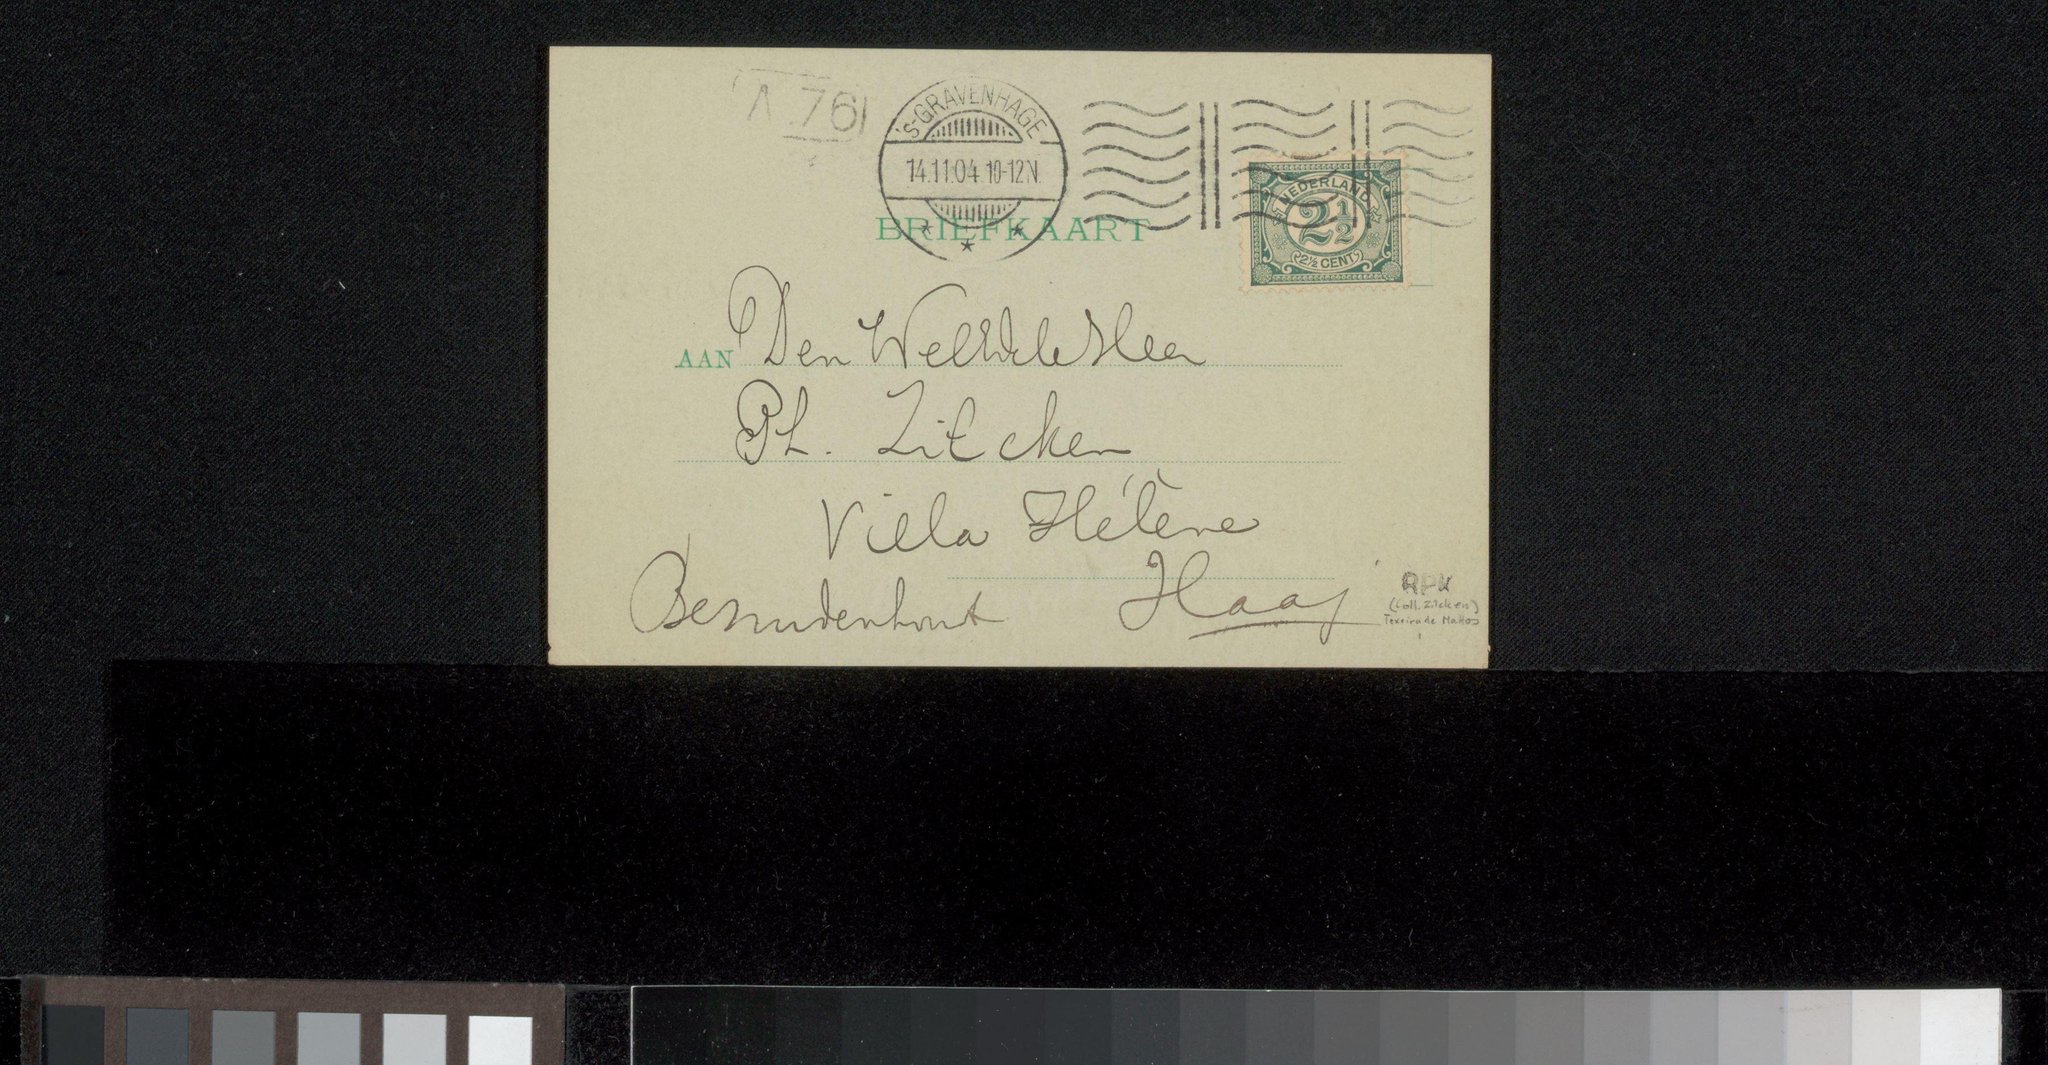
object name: postcard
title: Briefkaart aan Philip Zilcken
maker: henri teixeira de mattos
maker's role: painter, sculptor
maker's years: 1856-1908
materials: cardboard, ink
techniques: pen, writing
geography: the hague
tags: draughtsman, philip zilcken, photography, cinematography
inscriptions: collector's mark: ‘RPK’